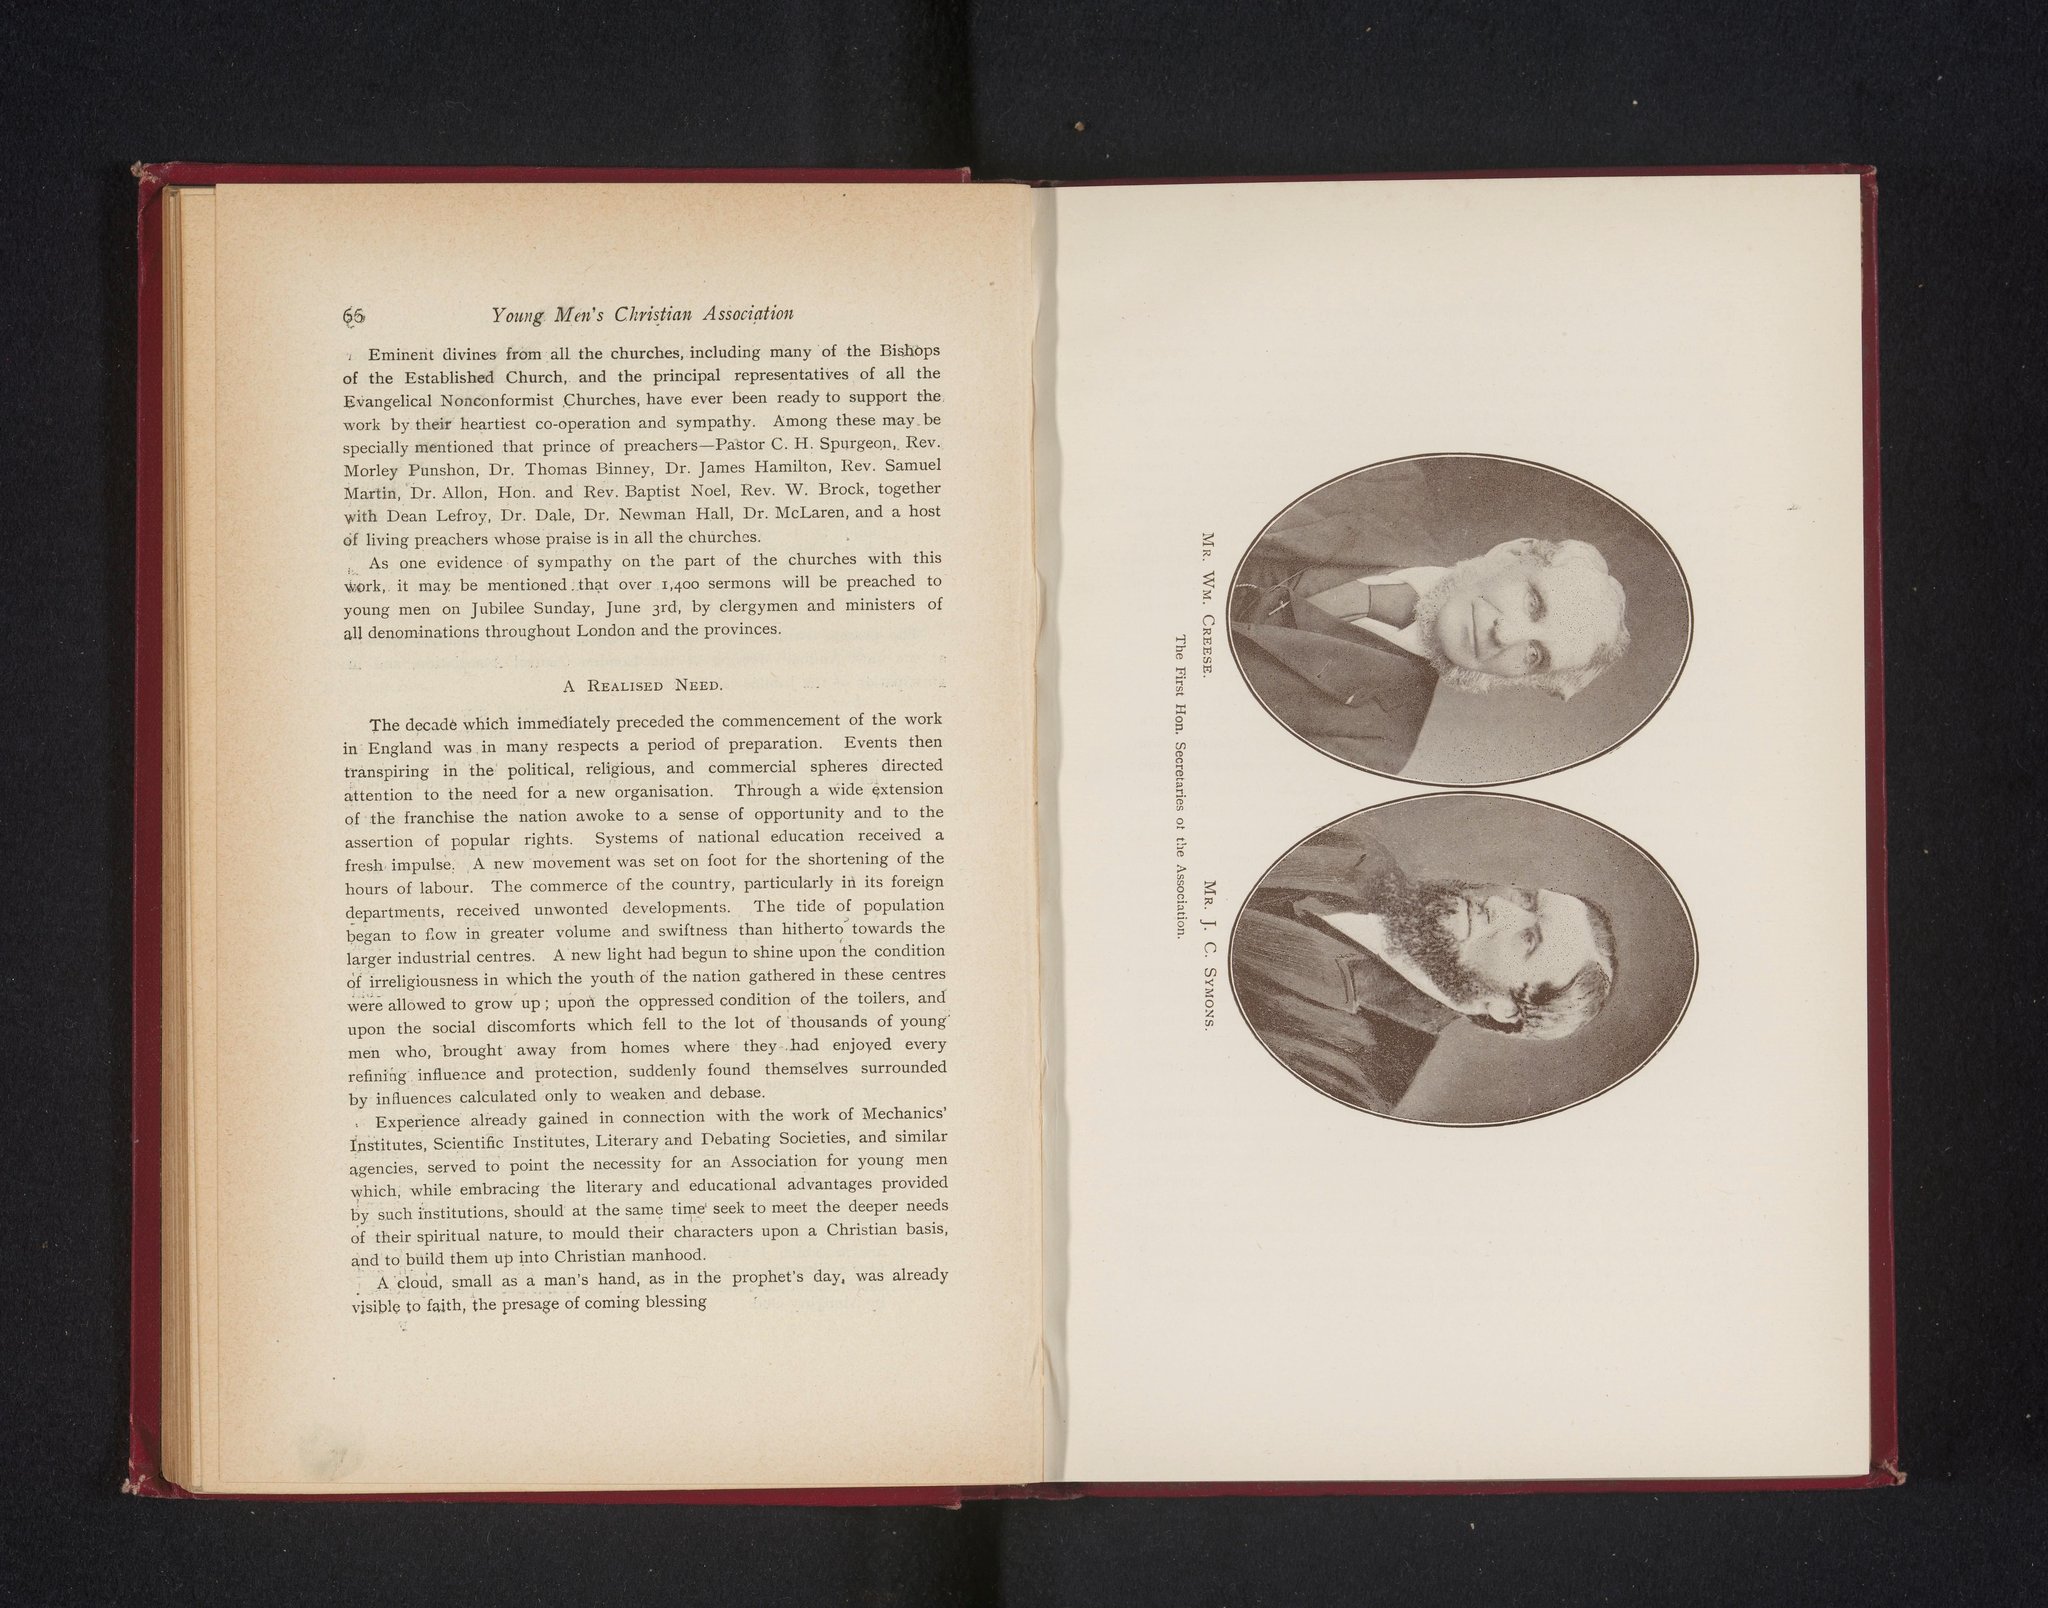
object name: photomechanical print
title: Twee portretten, afgebeeld William Creese en J.C. Symons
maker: Anonymous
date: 1890-1895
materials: paper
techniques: autotype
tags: historical persons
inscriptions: inscription: ‘The First Hon. Secretaries of the Association.’